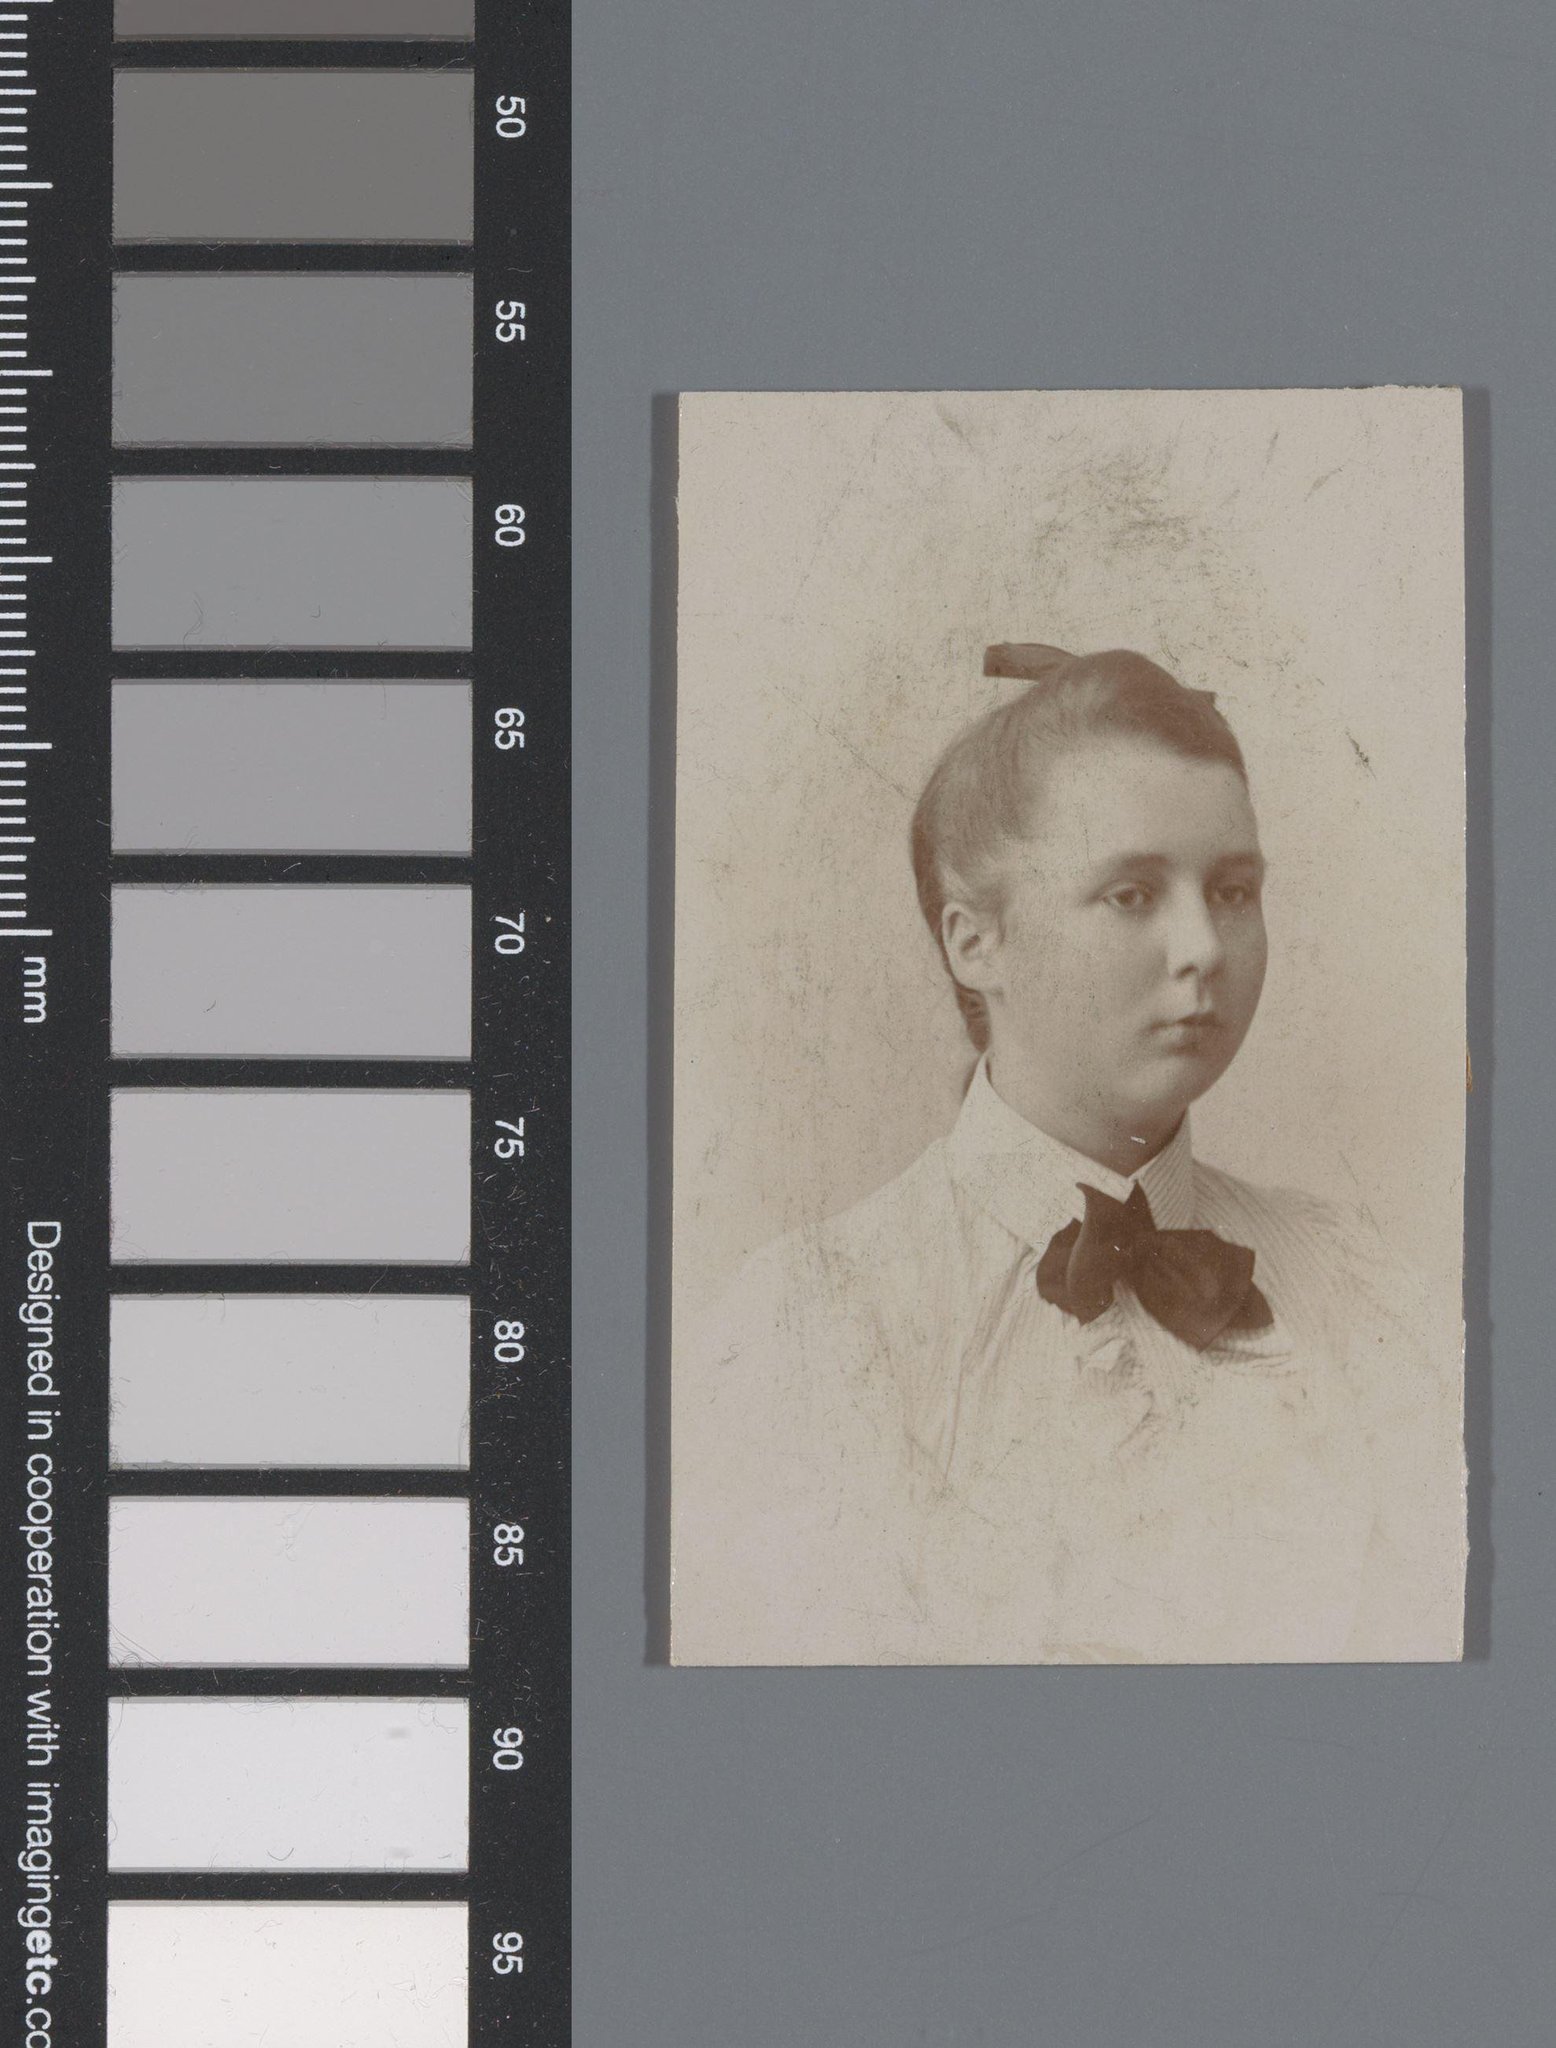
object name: photograph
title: Portret van een onbekende vrouw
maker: cornelis johannes lodewicus vermeulen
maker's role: fotograaf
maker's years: 1861-1936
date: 1900-1915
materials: cardboard, photographic support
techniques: gelatin silver print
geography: amsterdam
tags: adult woman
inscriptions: inscription: ‘J. L. Vermeulen Heerenstraat’